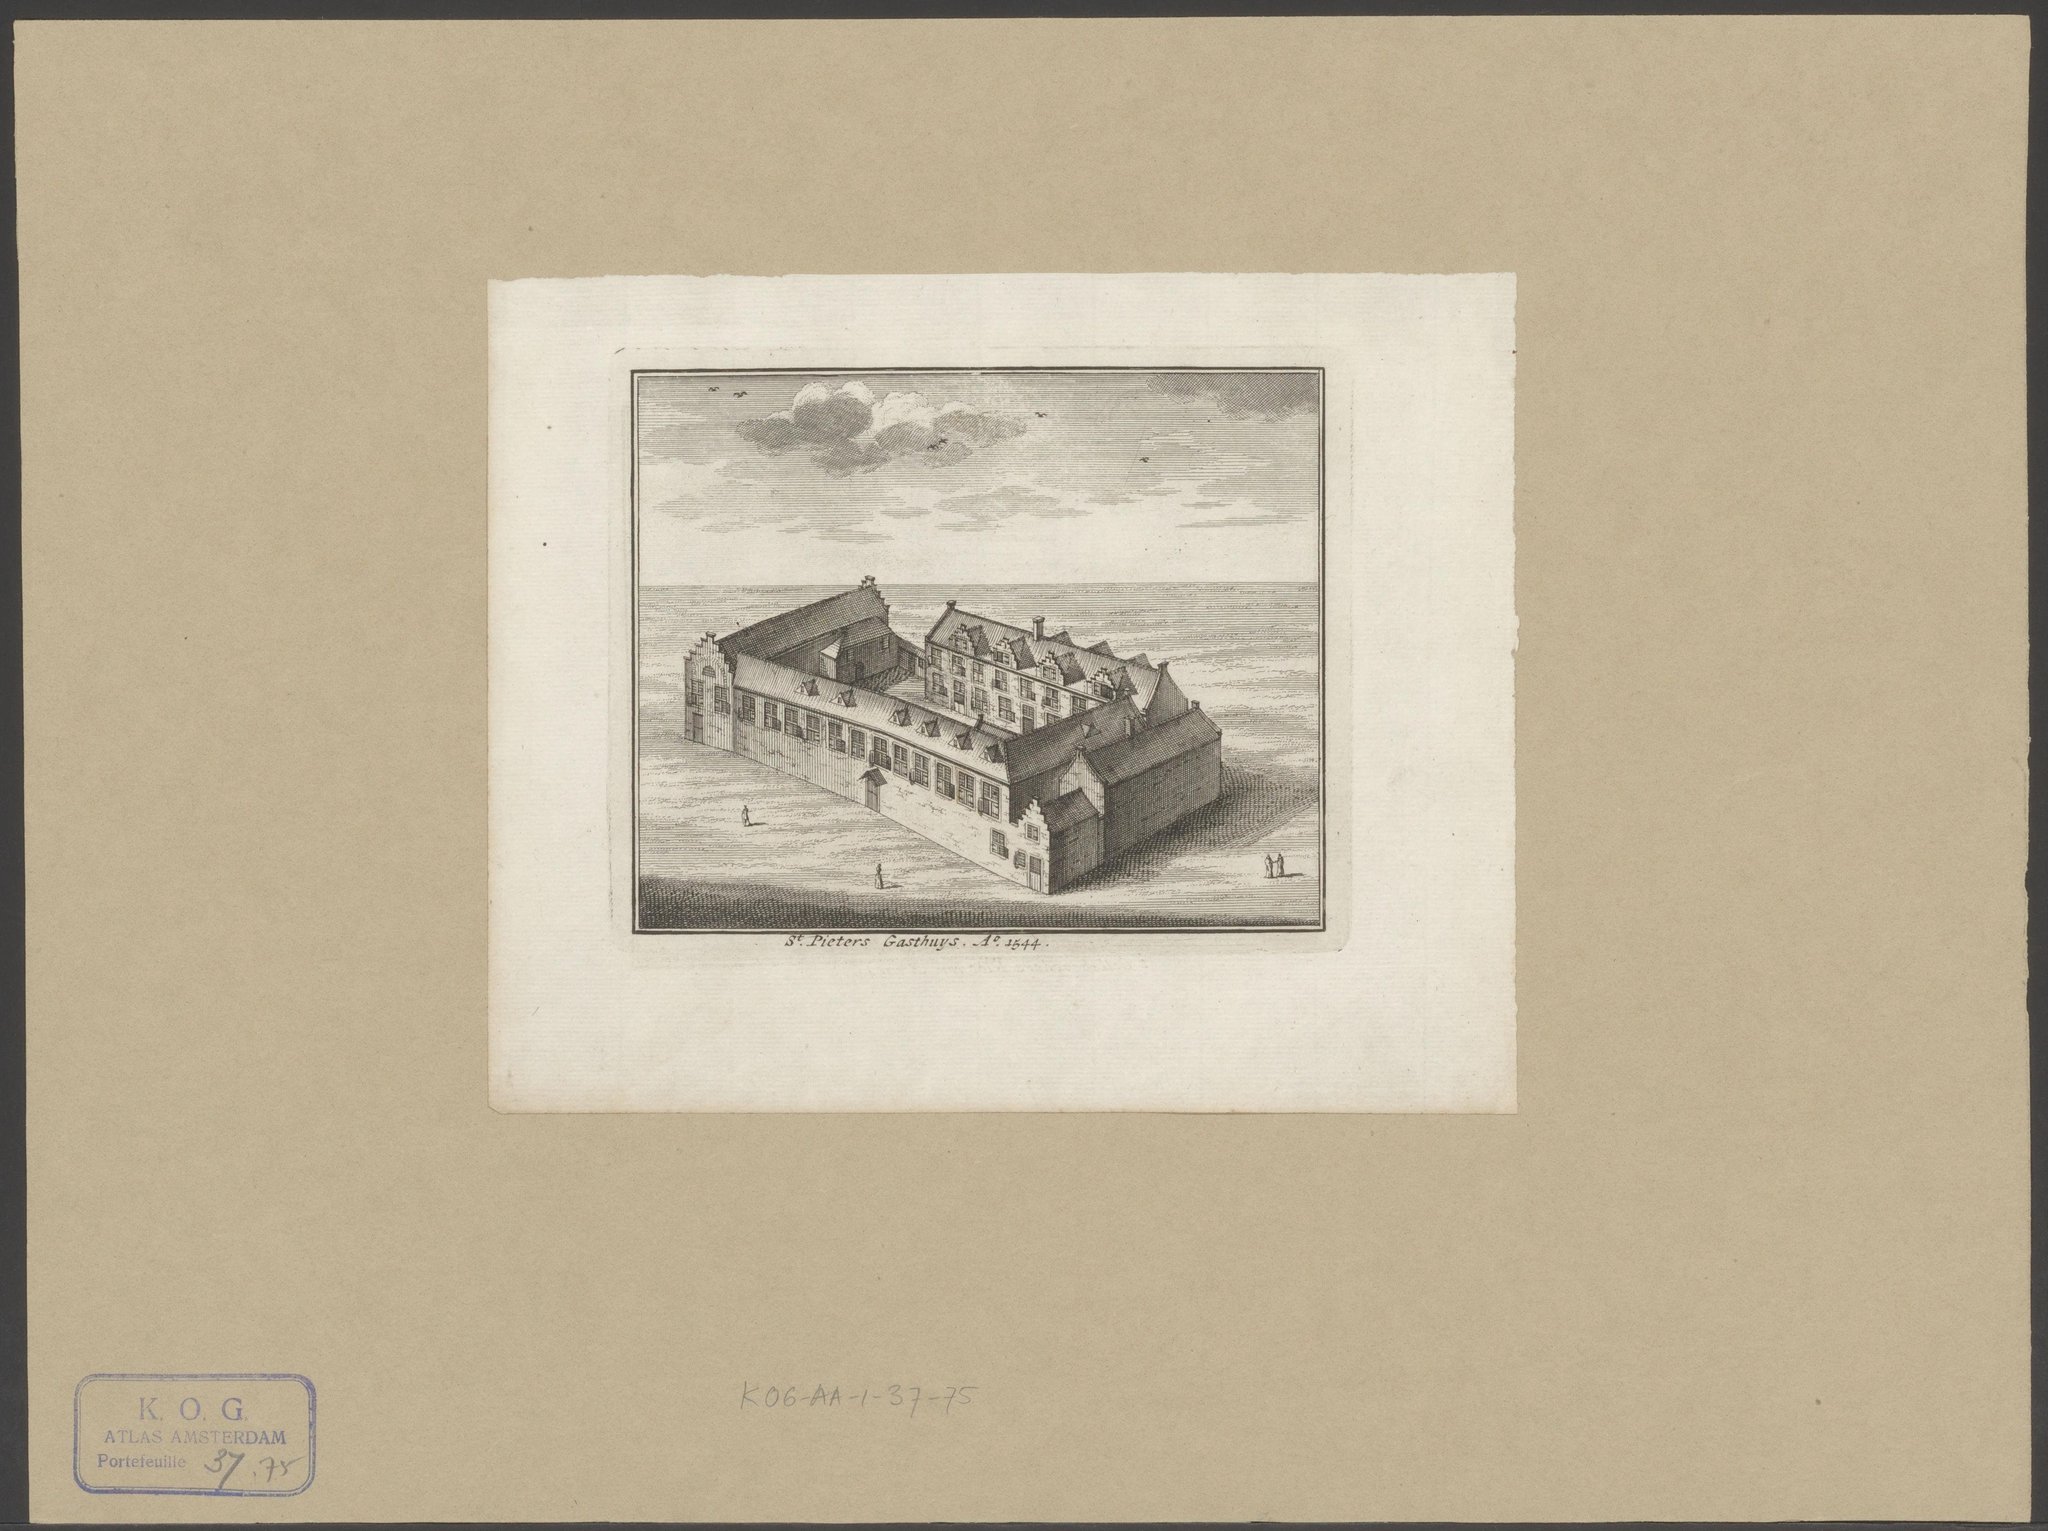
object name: print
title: Gezicht in vogelvlucht op het Sint-Pietersgasthuis te Amsterdam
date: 1729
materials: paper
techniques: engraving, etching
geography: amsterdam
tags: hospital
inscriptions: collector's mark: Lugt 1641b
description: Prent mogelijk uit: Long, Isaac le. Historische beschryvinge van de reformatie der stadt Amsterdam (…). Amsterdam: Johannes van Septeren (I), 1729. Dat de prent de situatie rond 1544 weergeeft, gaat terug op het feit dat voor het maken van deze en andere prenten van kloosters en kerken van voor de Alteratie (1578) is uitgegaan van de plattegrond van Cornelis Anthonisz. uit 1544, zie RP-P-OB-70.399 en RP-P-AO-20-15.